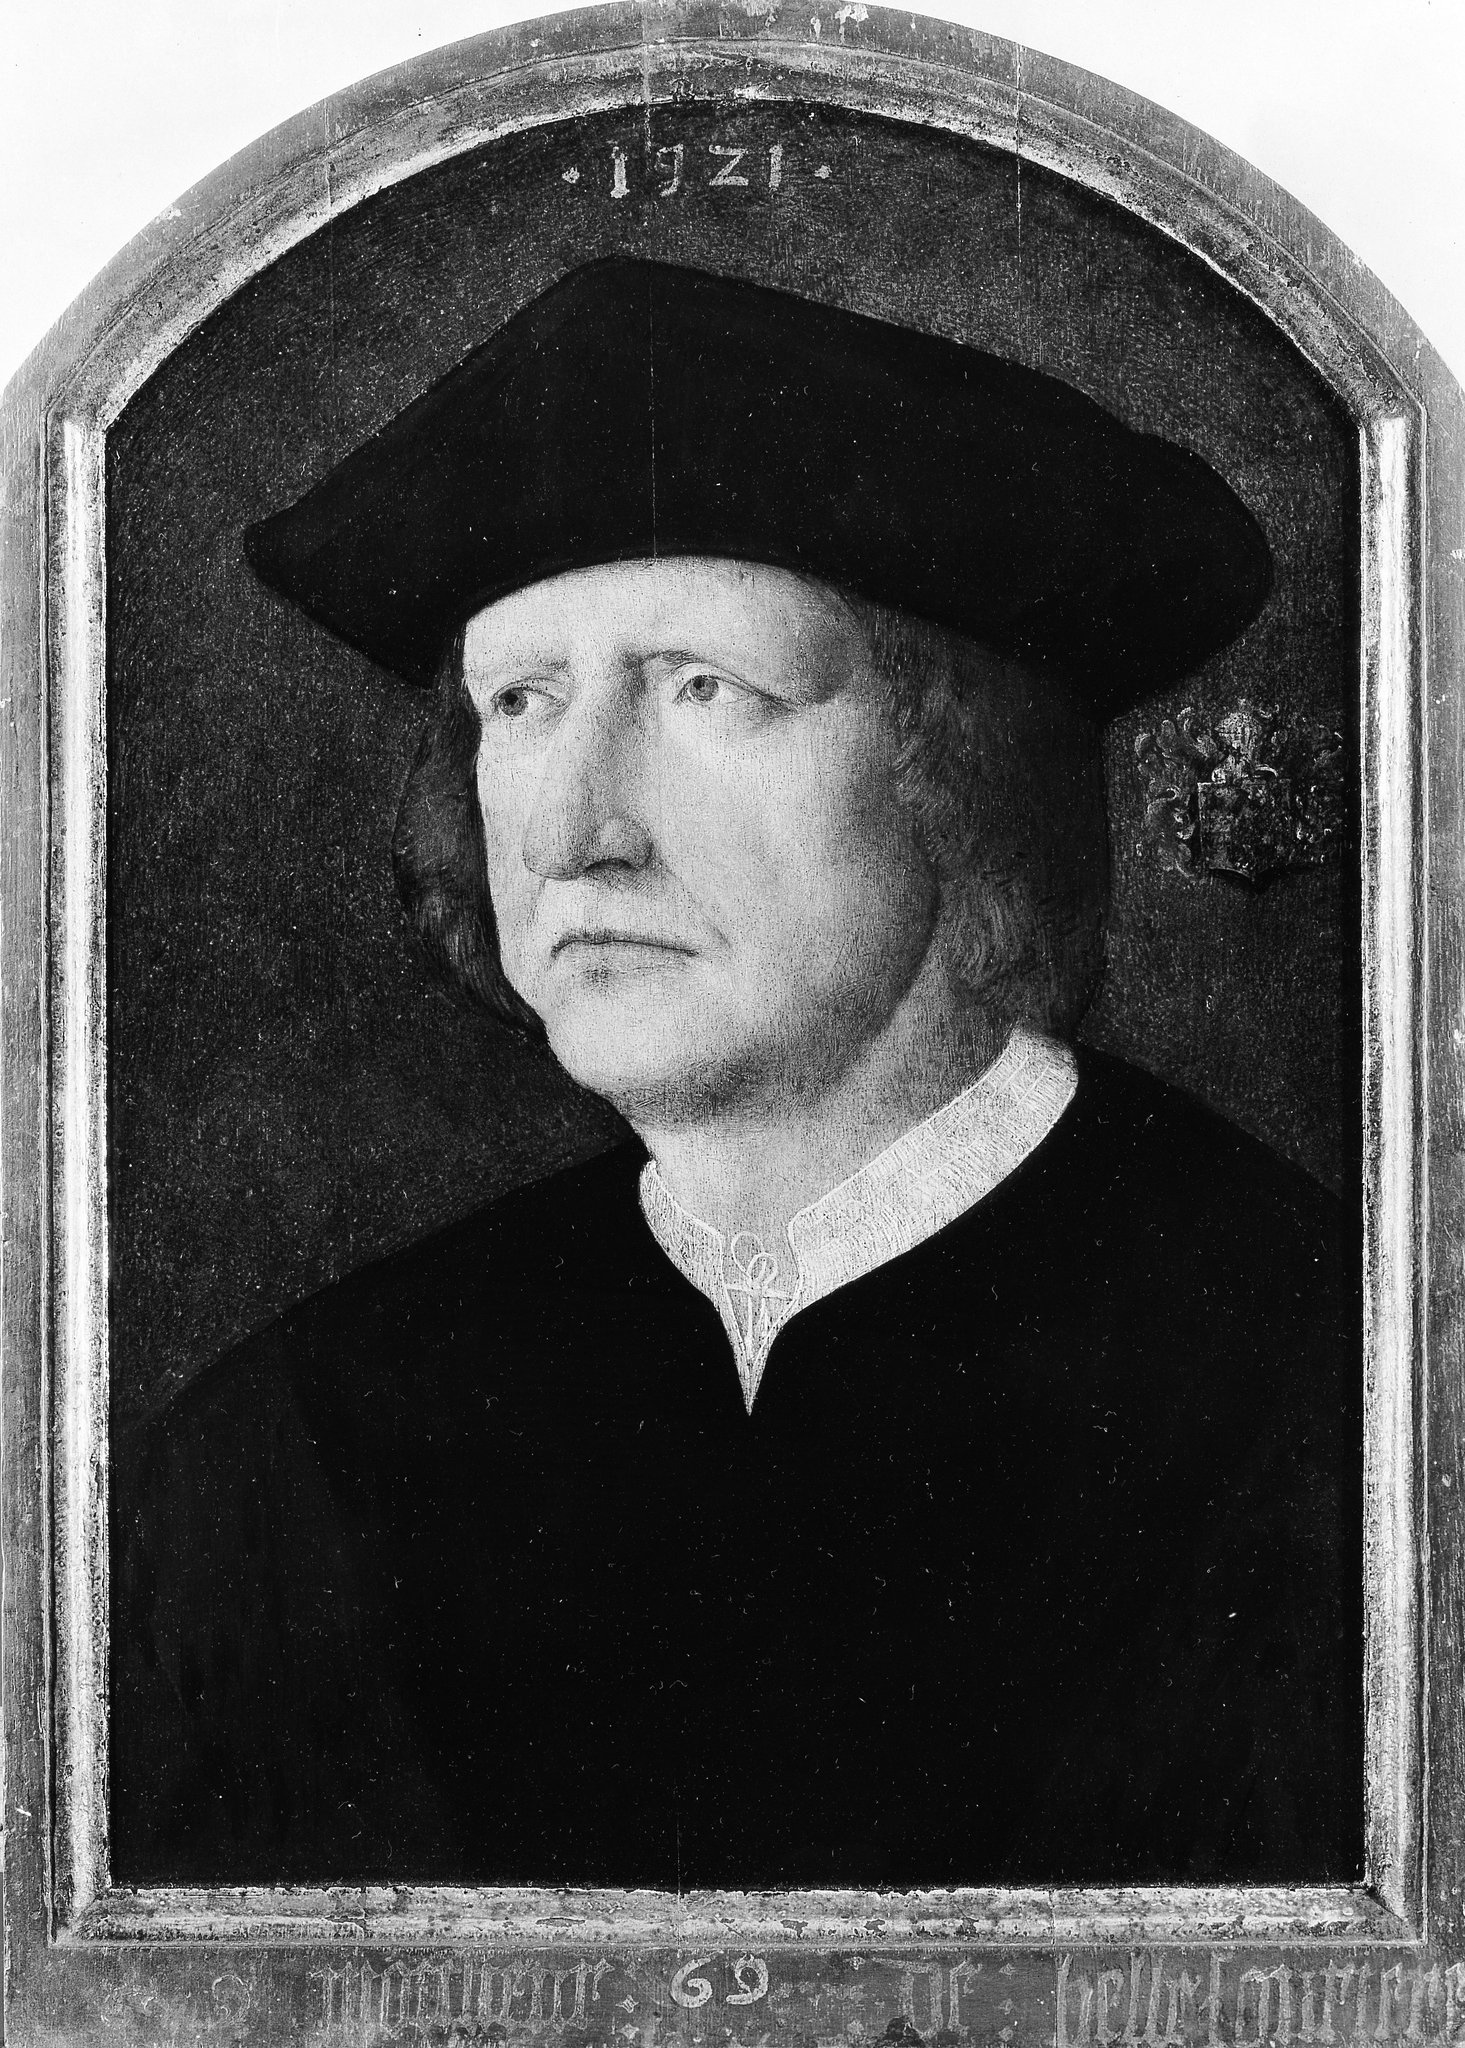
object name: painting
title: Monsieur de Bellefourière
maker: french painter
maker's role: artist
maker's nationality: french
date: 1521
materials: oil, wood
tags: men,portraits